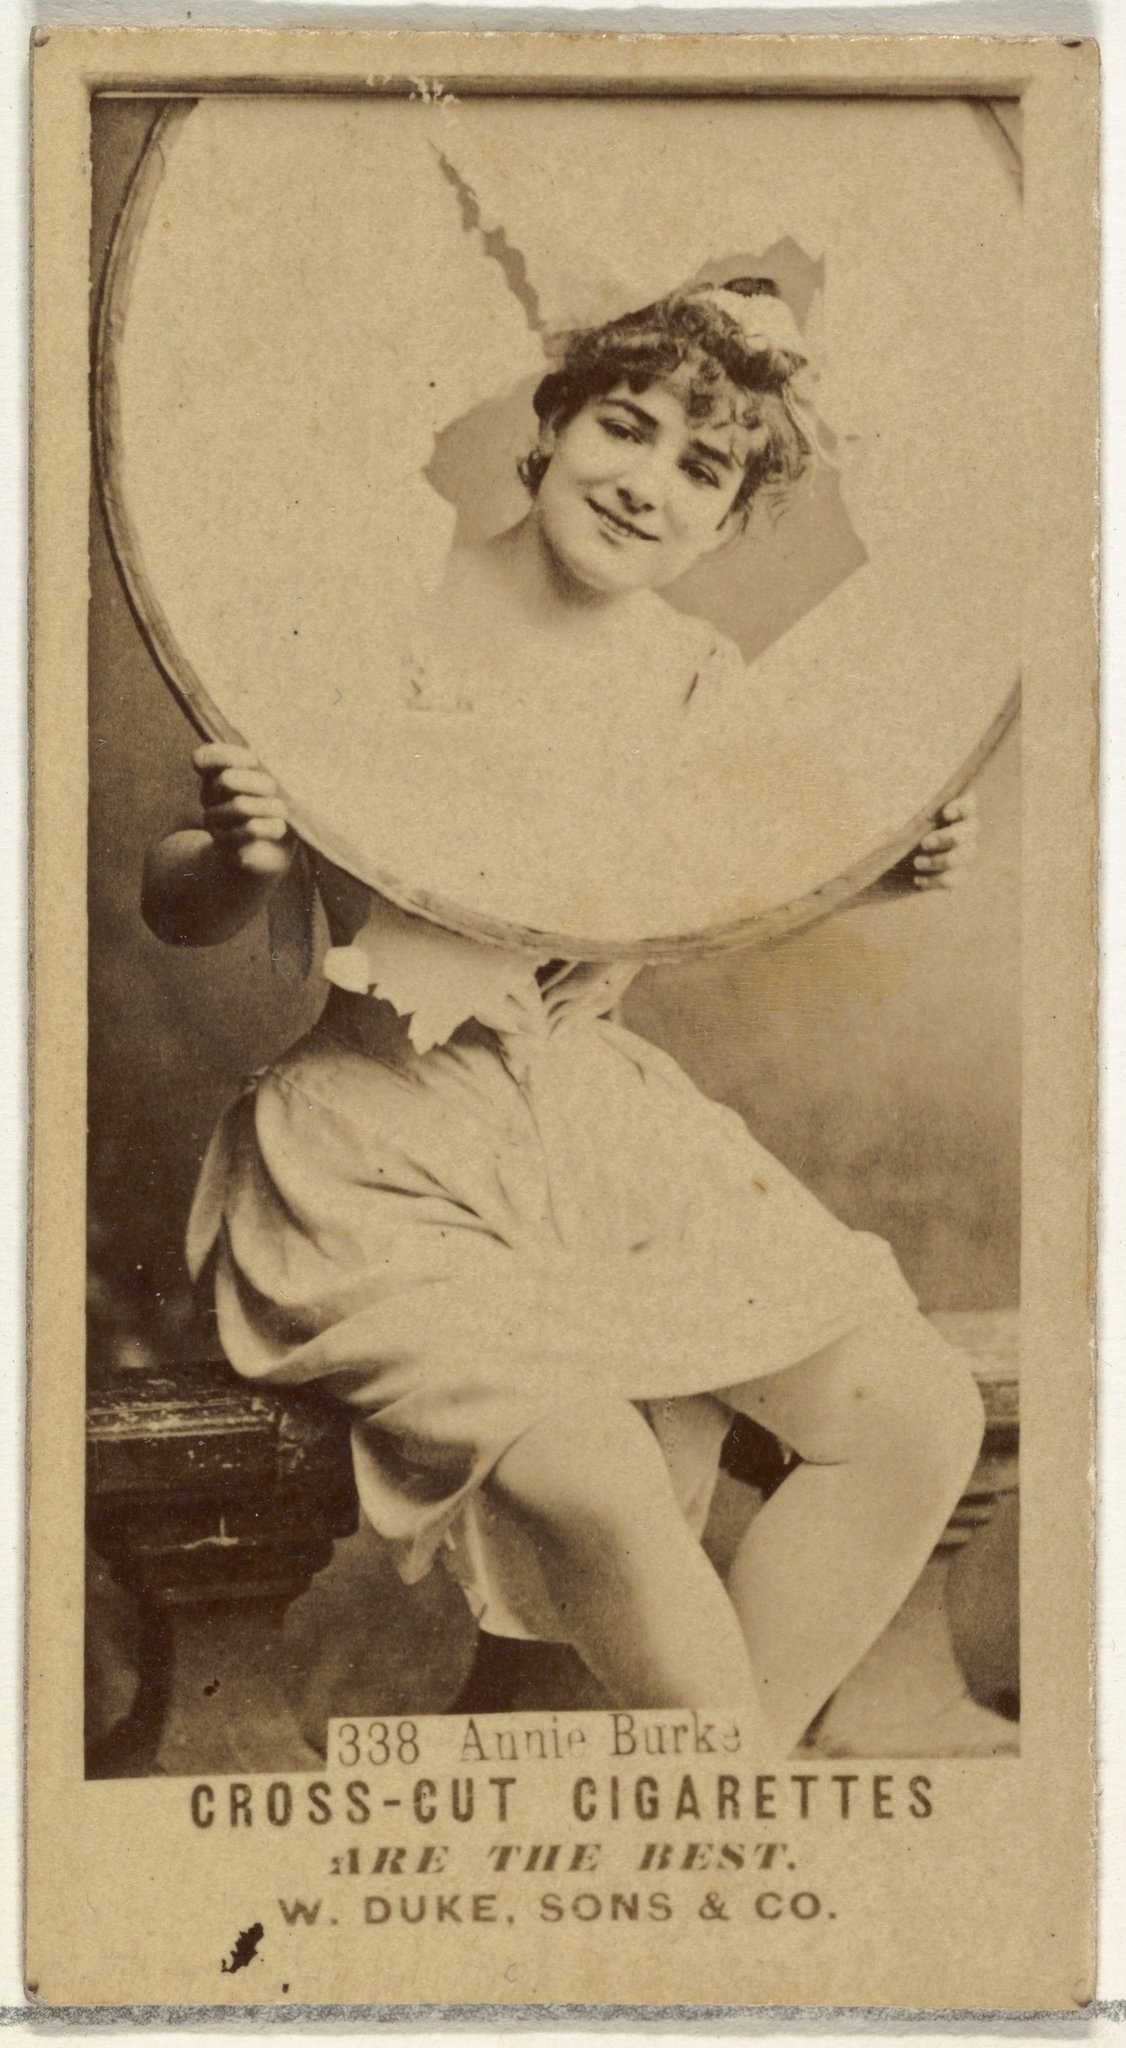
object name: photograph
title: Card Number 338, Annie Burks, from the Actors and Actresses series (N145-3) issued by Duke Sons & Co. to promote Cross Cut Cigarettes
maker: w. duke, sons & co.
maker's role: publisher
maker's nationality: american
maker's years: 1870-1920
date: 1880-1889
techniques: albumen silver print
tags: portraits,women,actresses